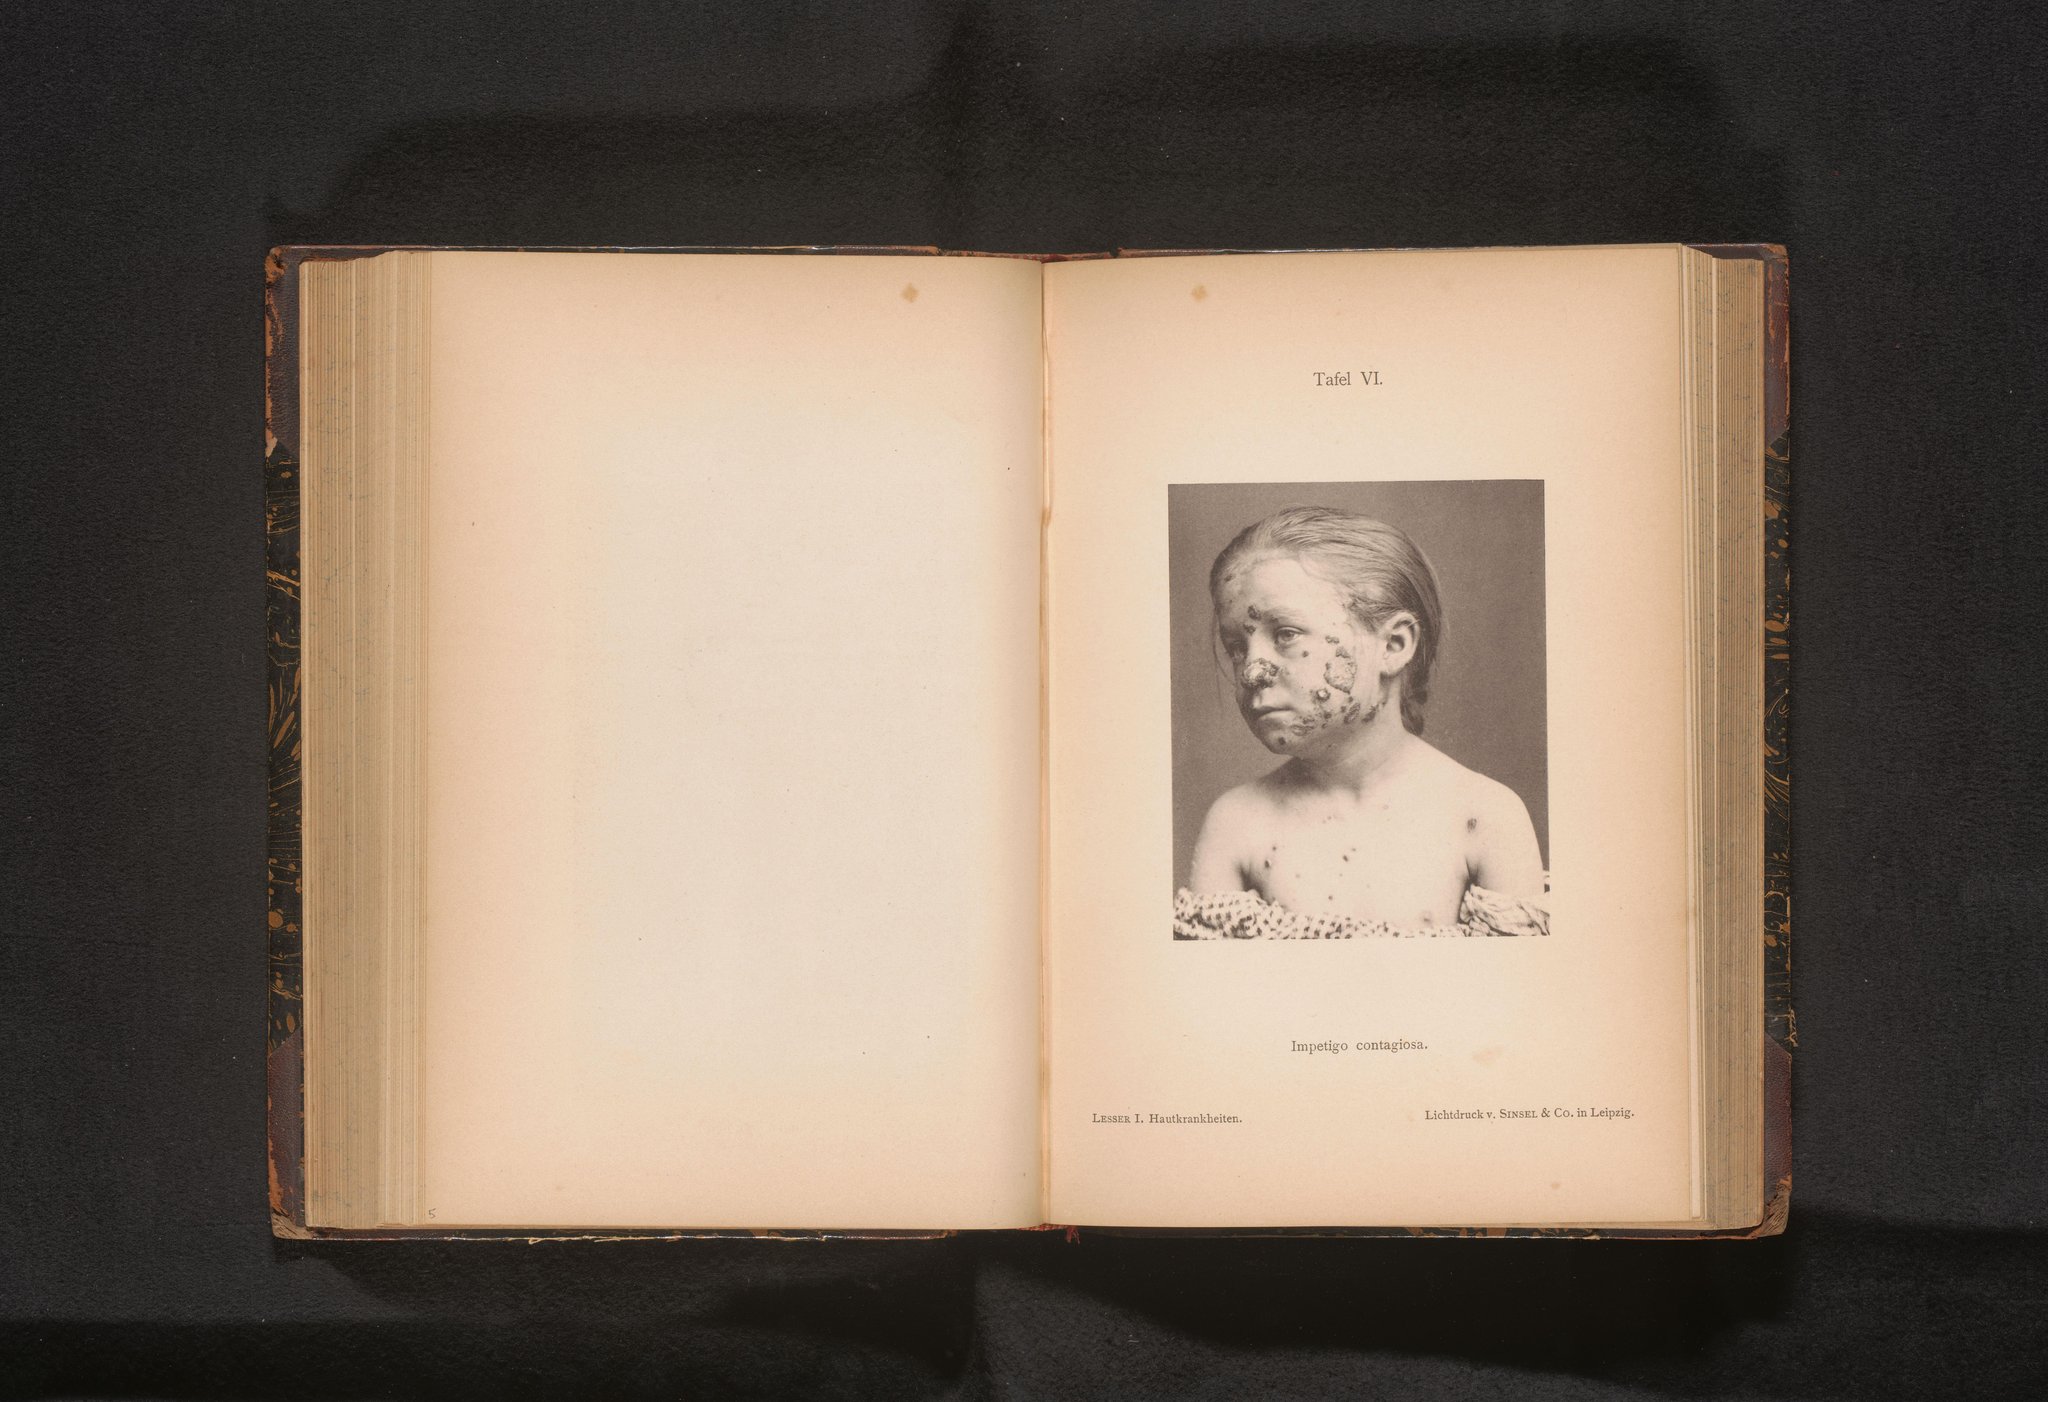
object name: photomechanical print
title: Impetigo contagiosa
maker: Anonymous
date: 1879-1889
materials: paper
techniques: photograph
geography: germany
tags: skin and venereal diseases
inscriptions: number: ‘Tafel VI.’